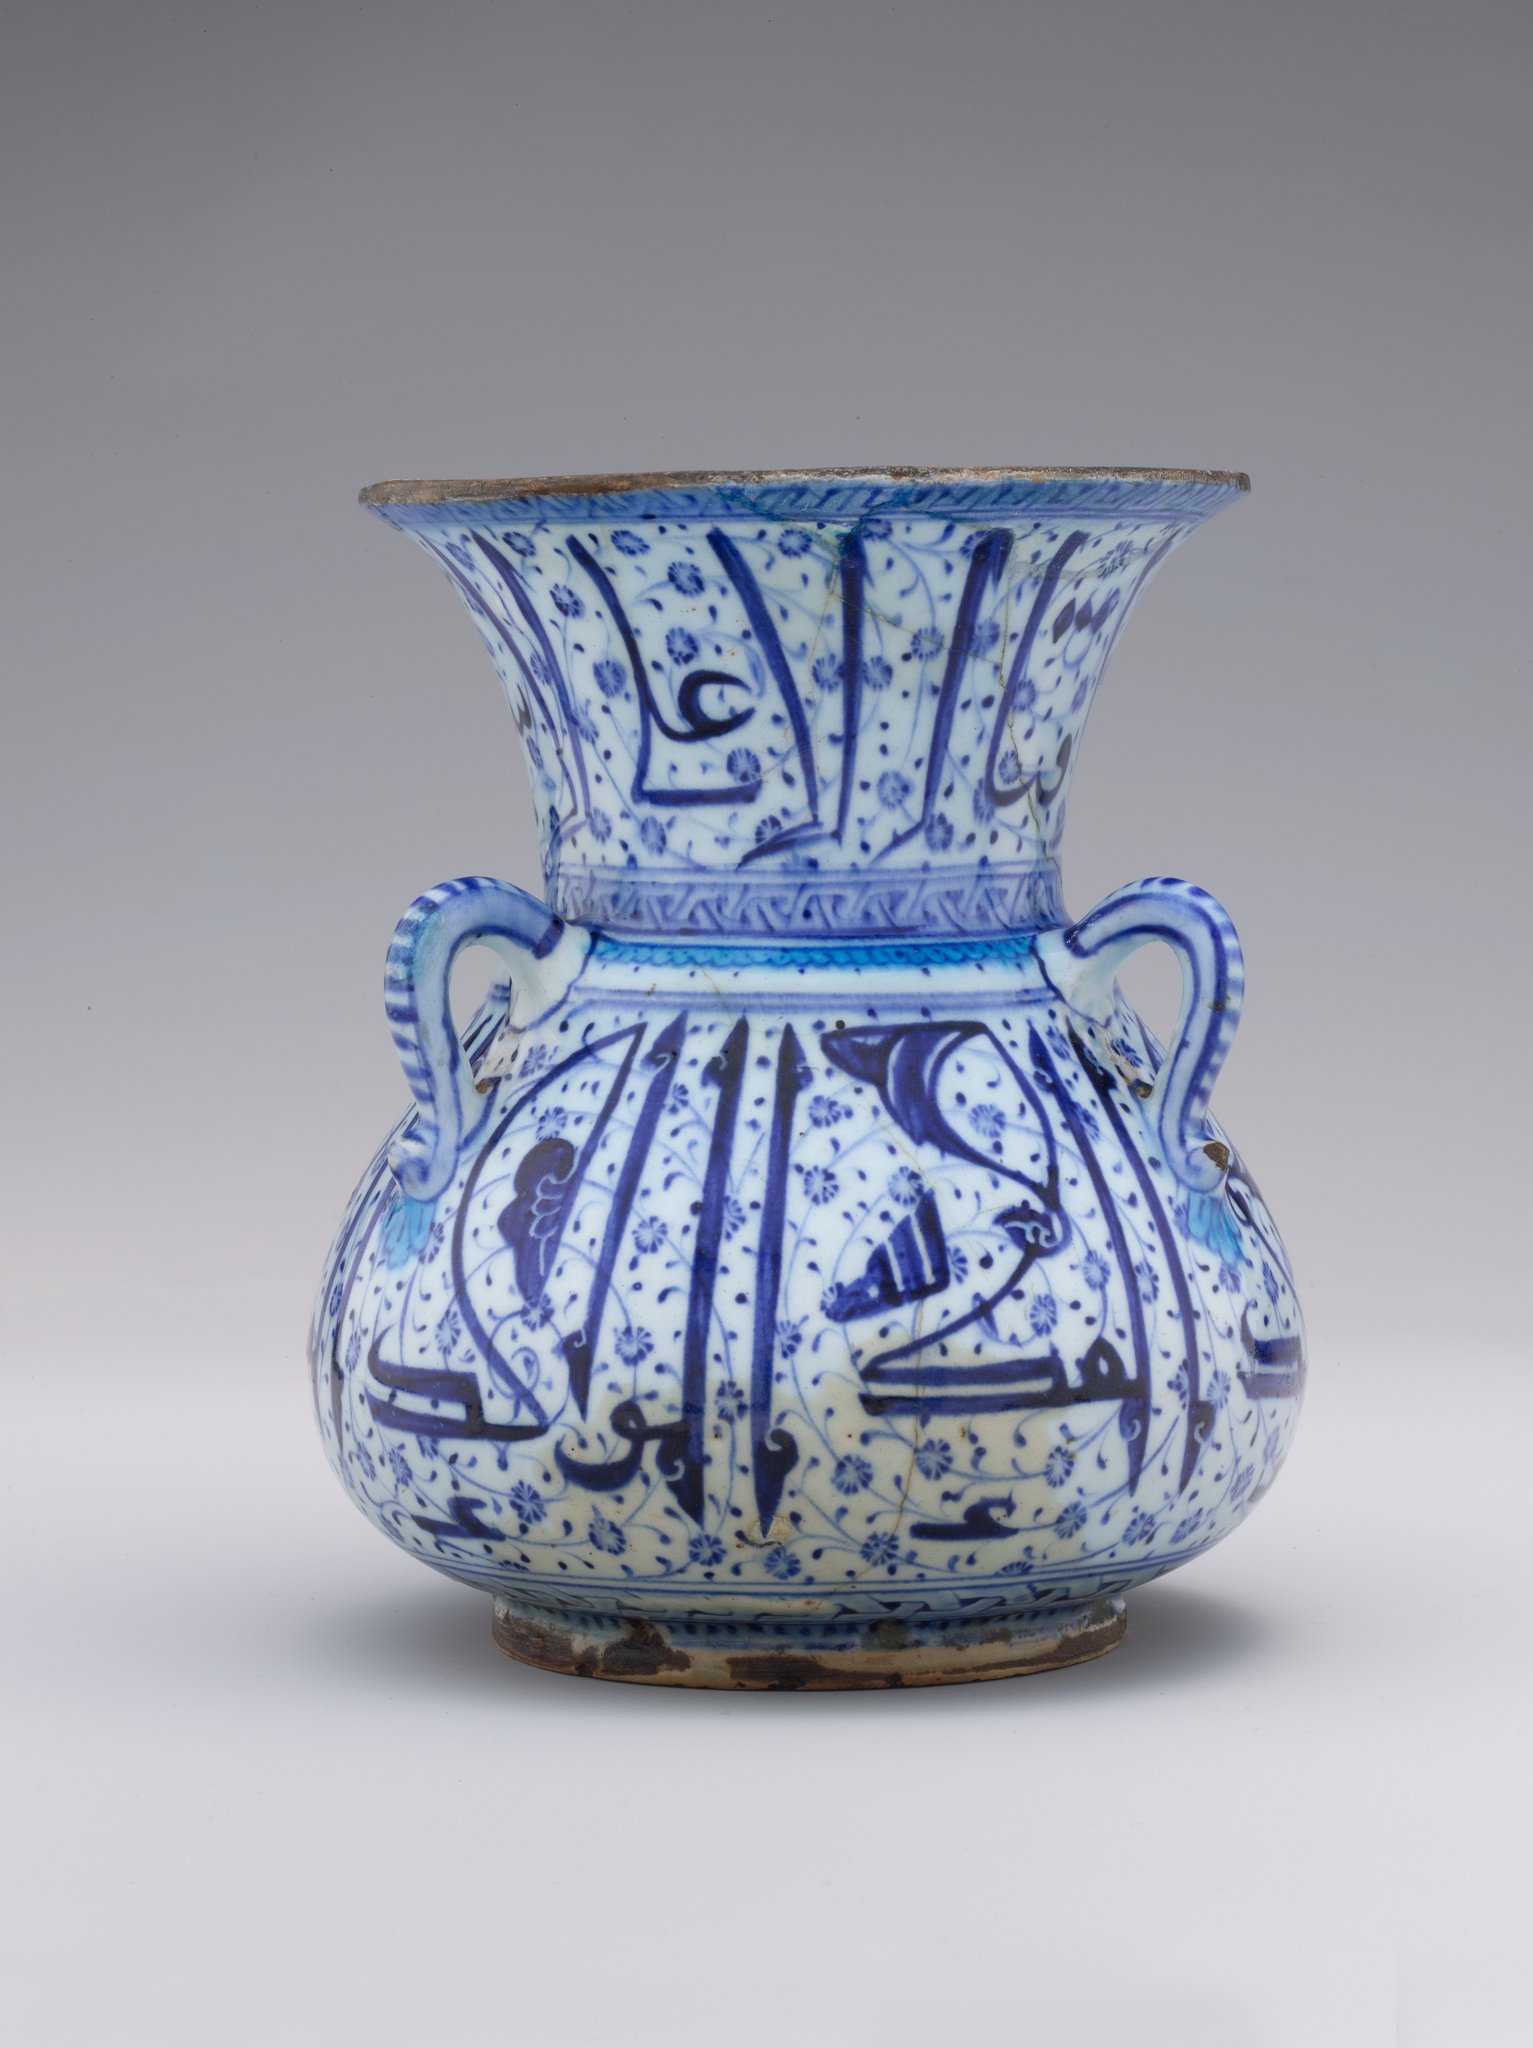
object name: mosque lamp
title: Ceramic Vessel in the Shape of a Mosque Lamp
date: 1525-1540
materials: glaze, stonepaste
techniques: painting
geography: turkey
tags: arabic